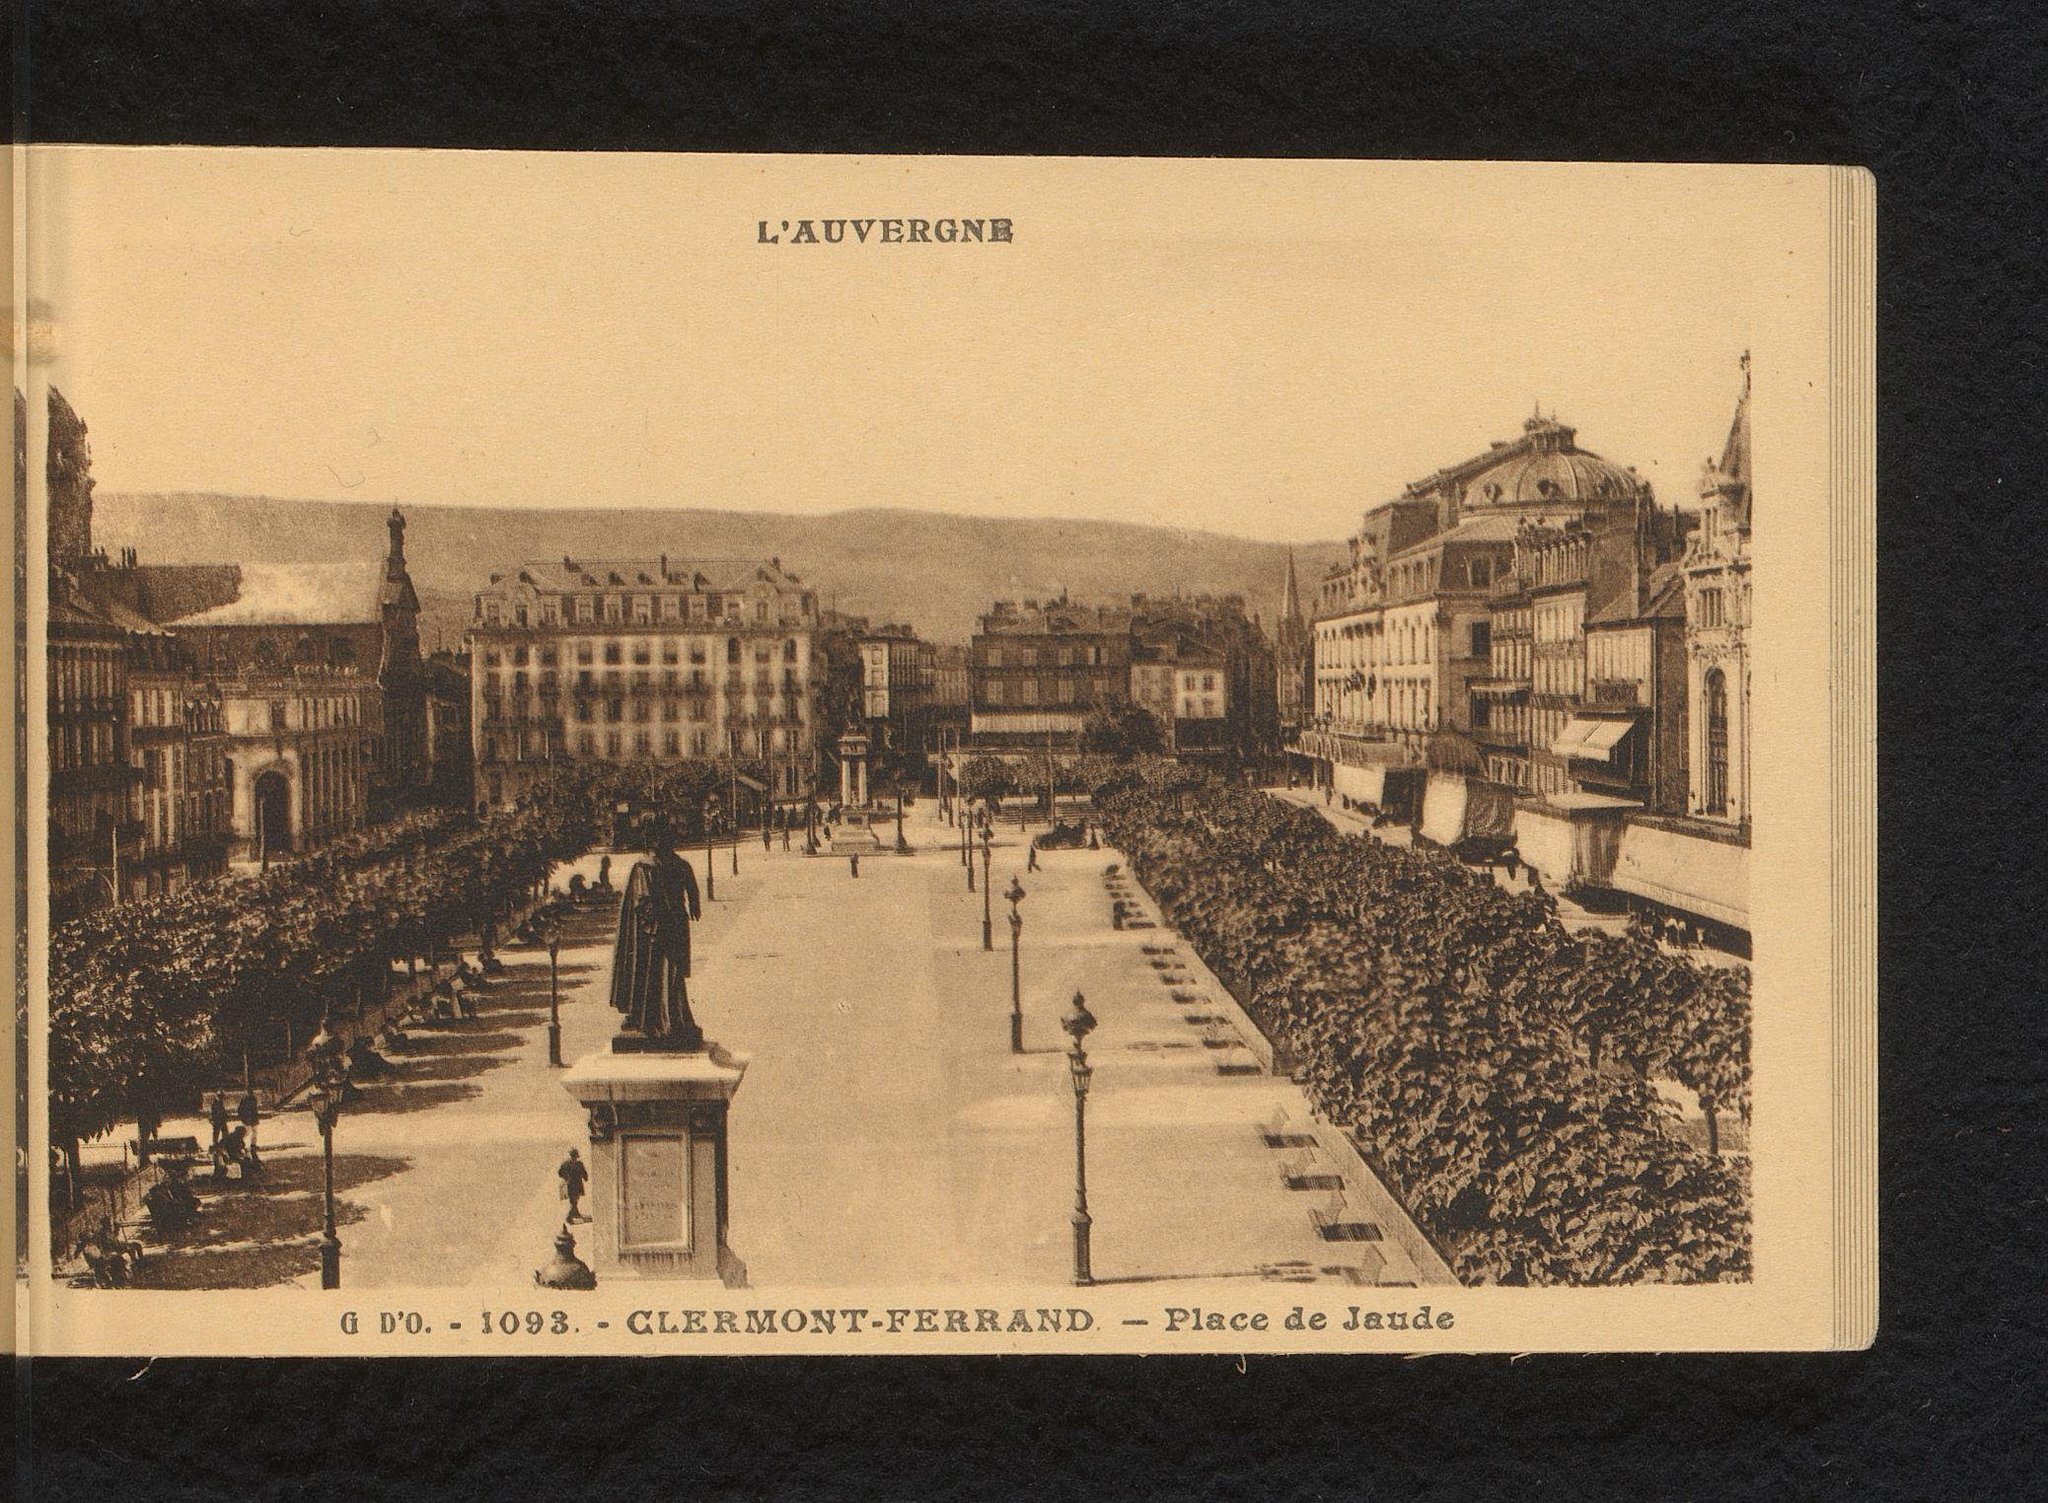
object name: ansichtkaart, prentbriefkaart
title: Clermont-Ferrand. Place de Jaude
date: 1921-1930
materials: cardboard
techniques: photograph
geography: clermont-ferrand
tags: monument, statue, square, place, circus, etc. (+ city(-scape) with figures, staffage), mountains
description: Prentbriefkaart maakt deel uit van een album.